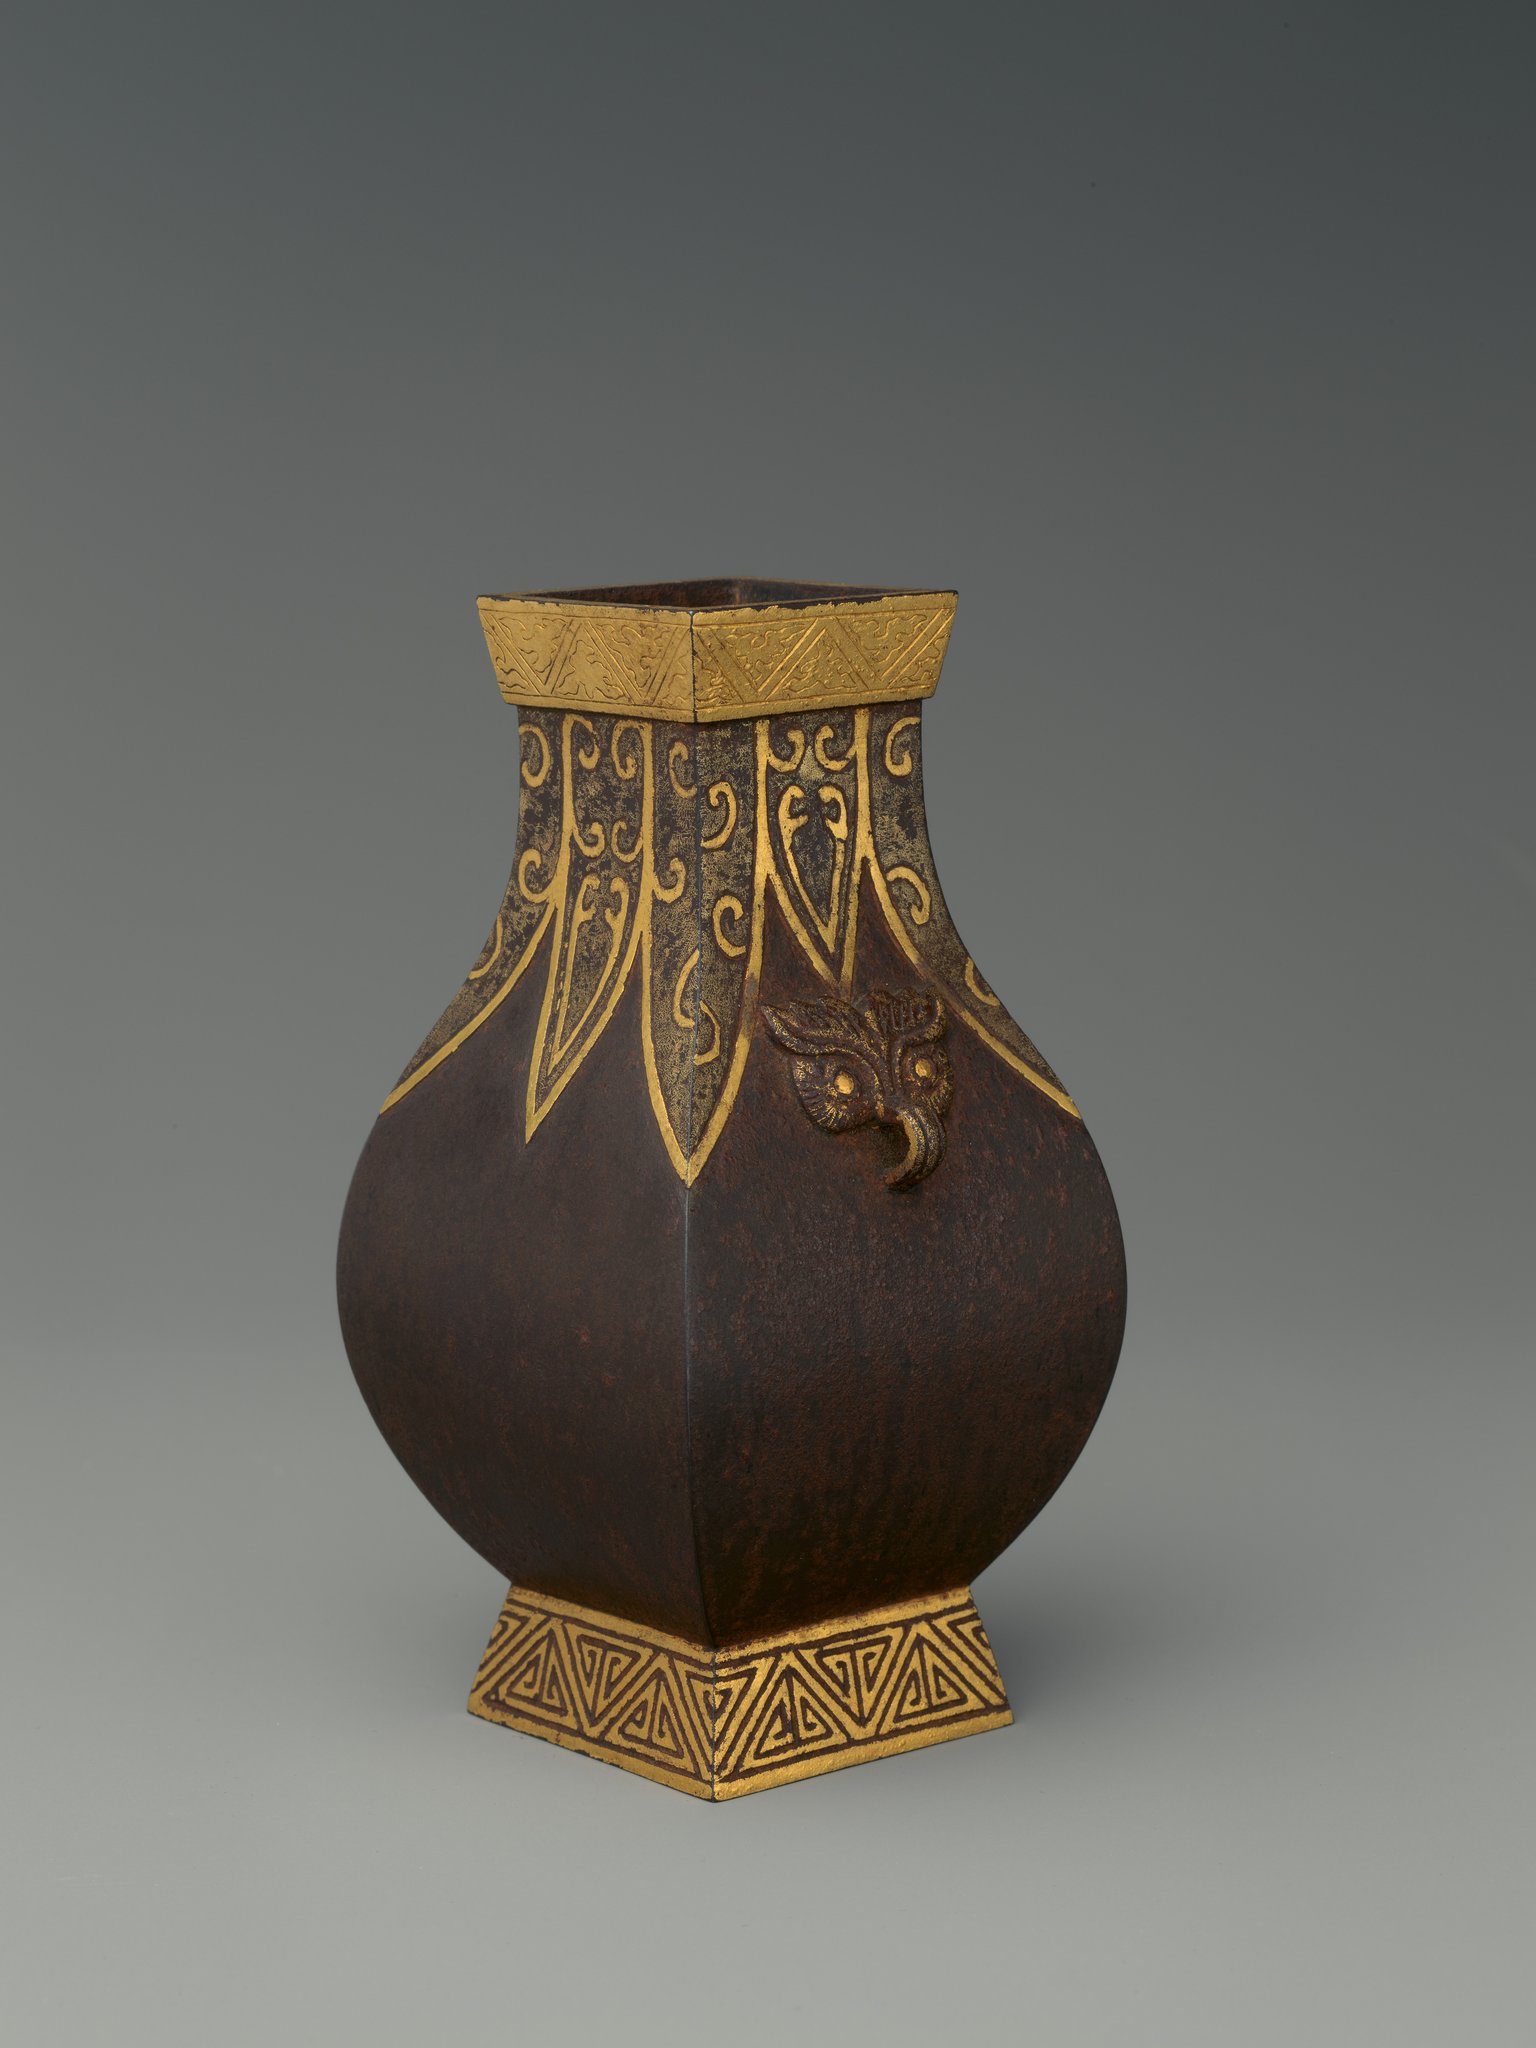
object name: vase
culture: japanese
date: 1851-1900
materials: iron